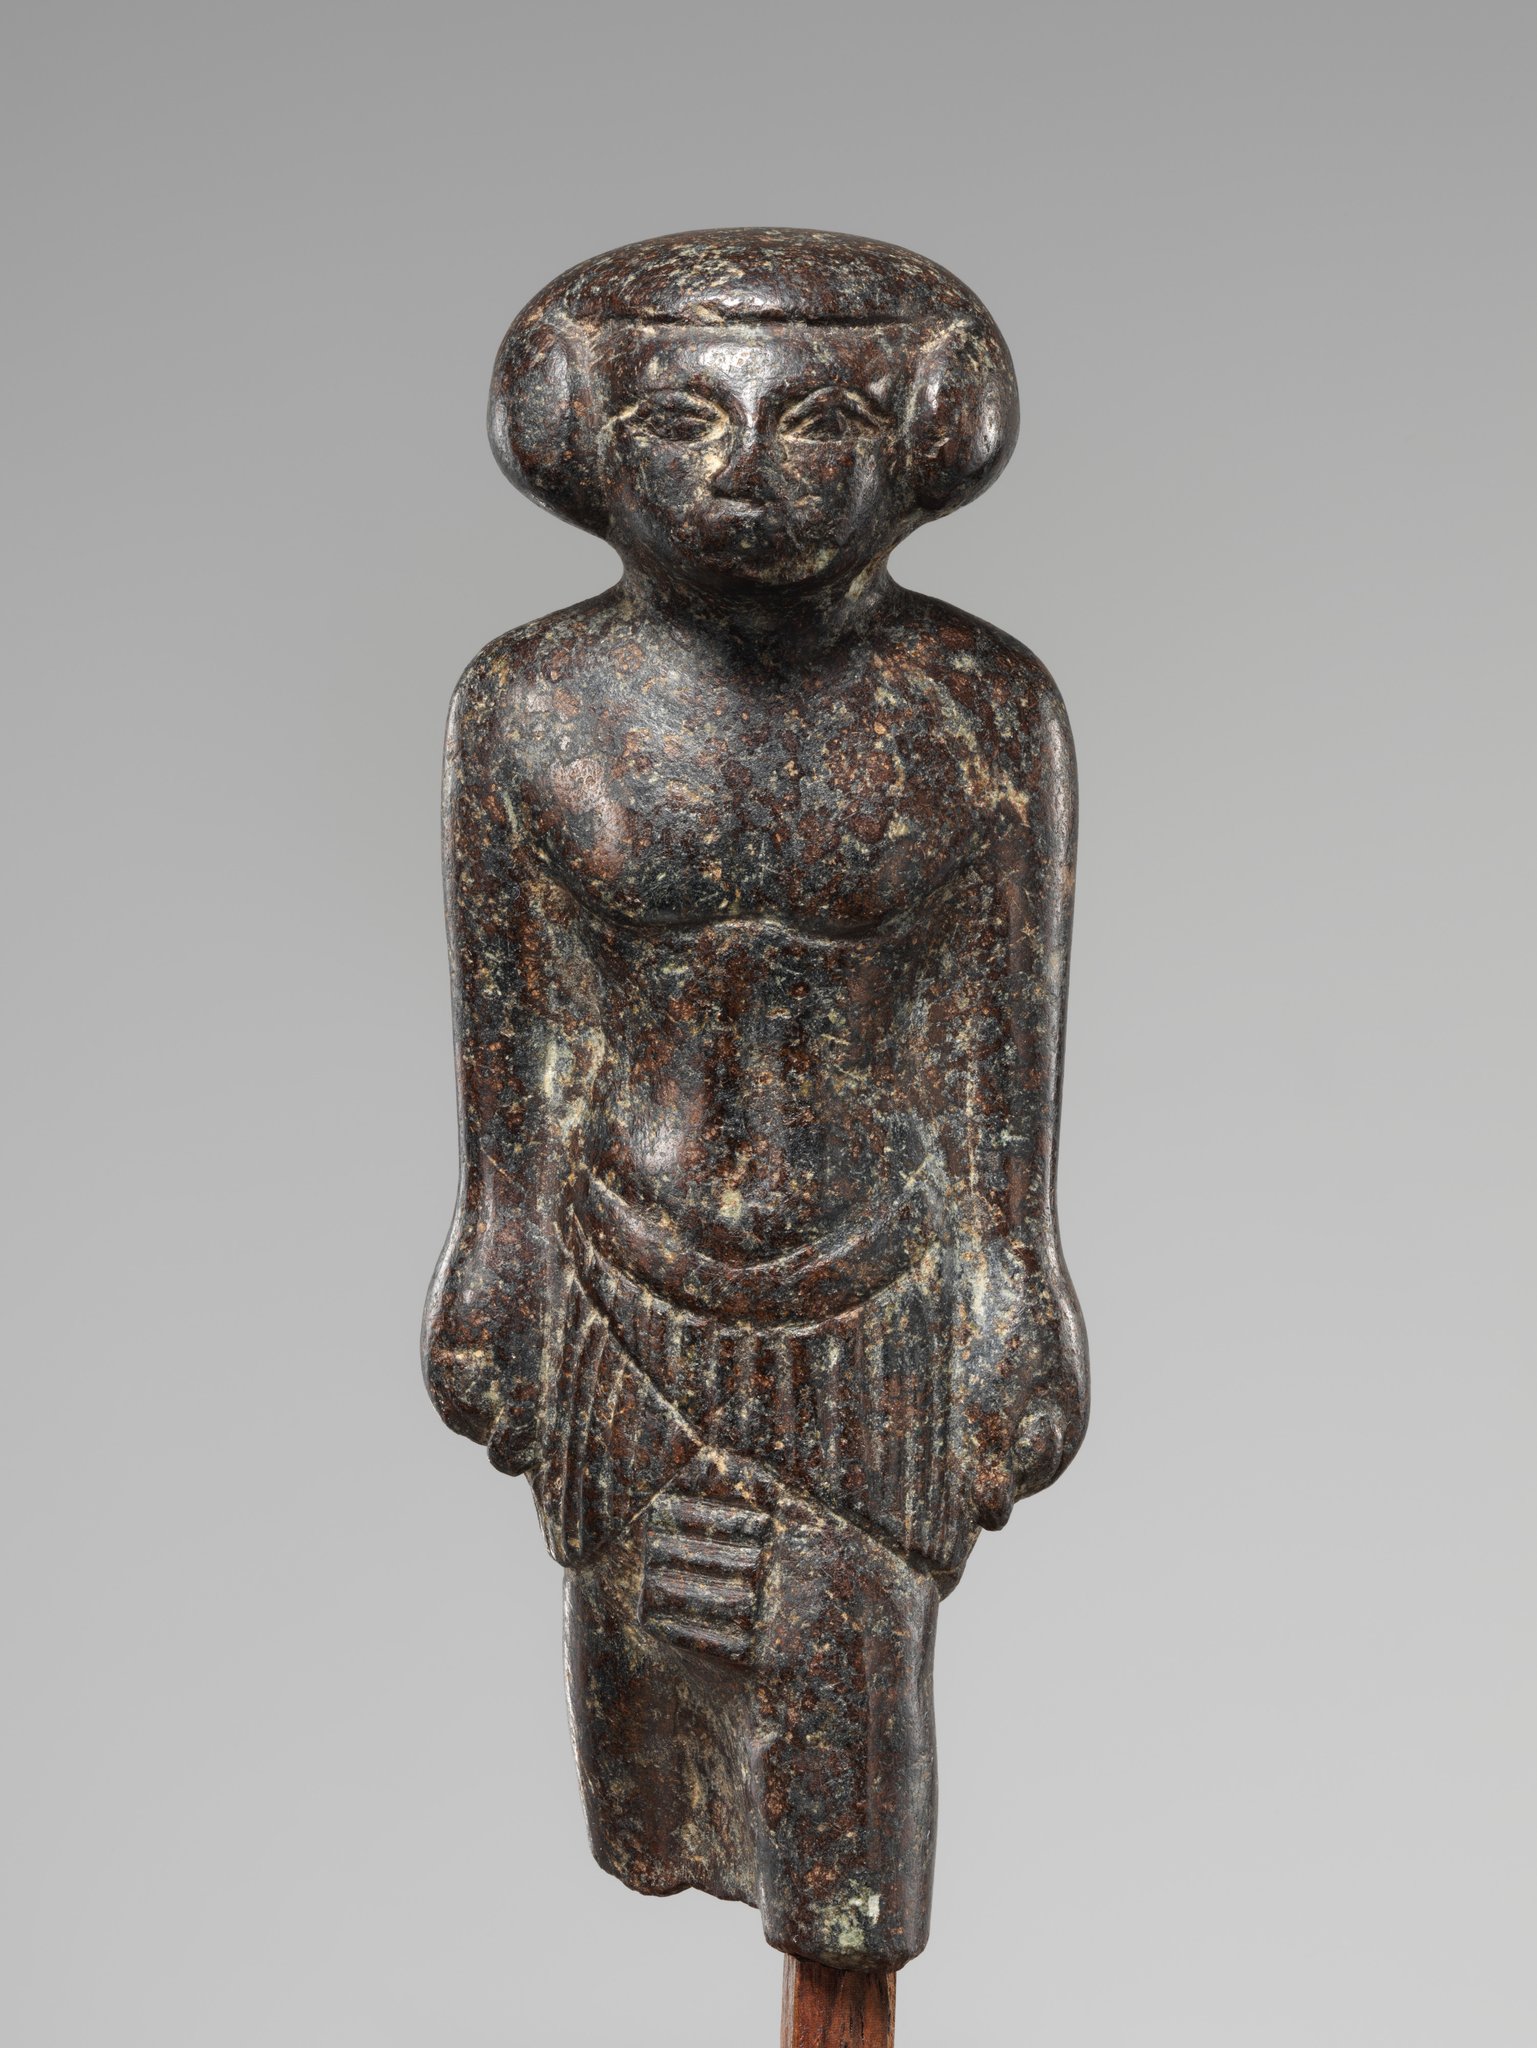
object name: figure of a striding man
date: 1650-1550 BCE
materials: stone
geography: egypt